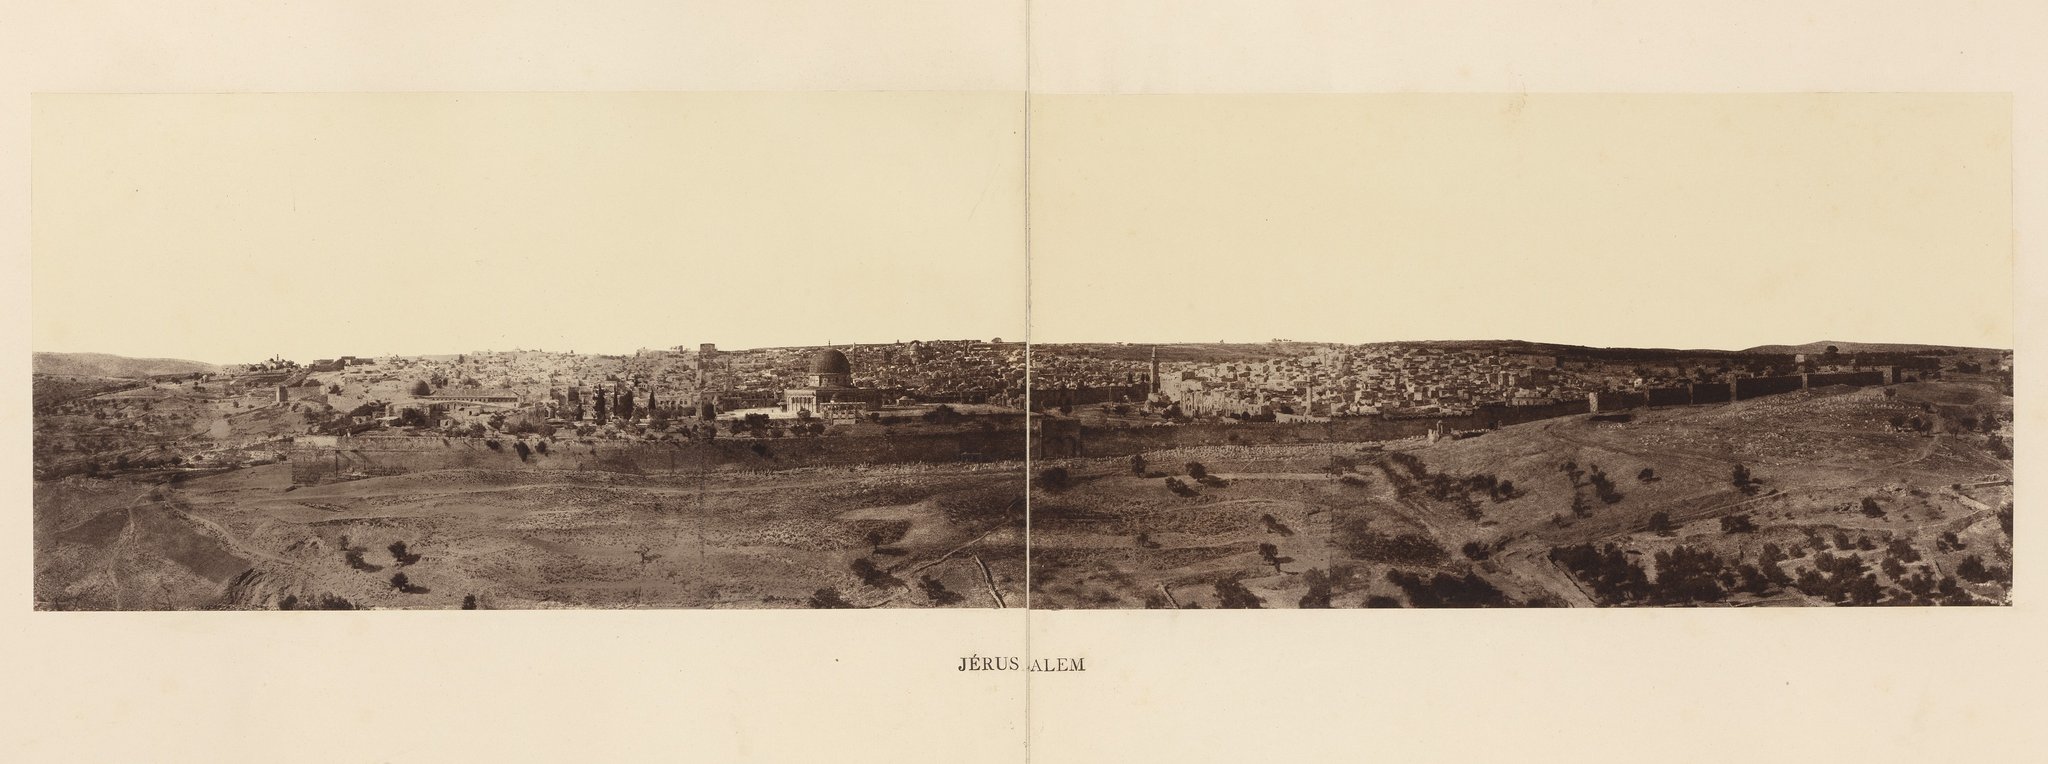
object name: photograph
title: Jérusalem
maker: louis de clercq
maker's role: artist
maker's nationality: french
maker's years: 1837-1901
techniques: albumen silver print, paper negative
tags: cities